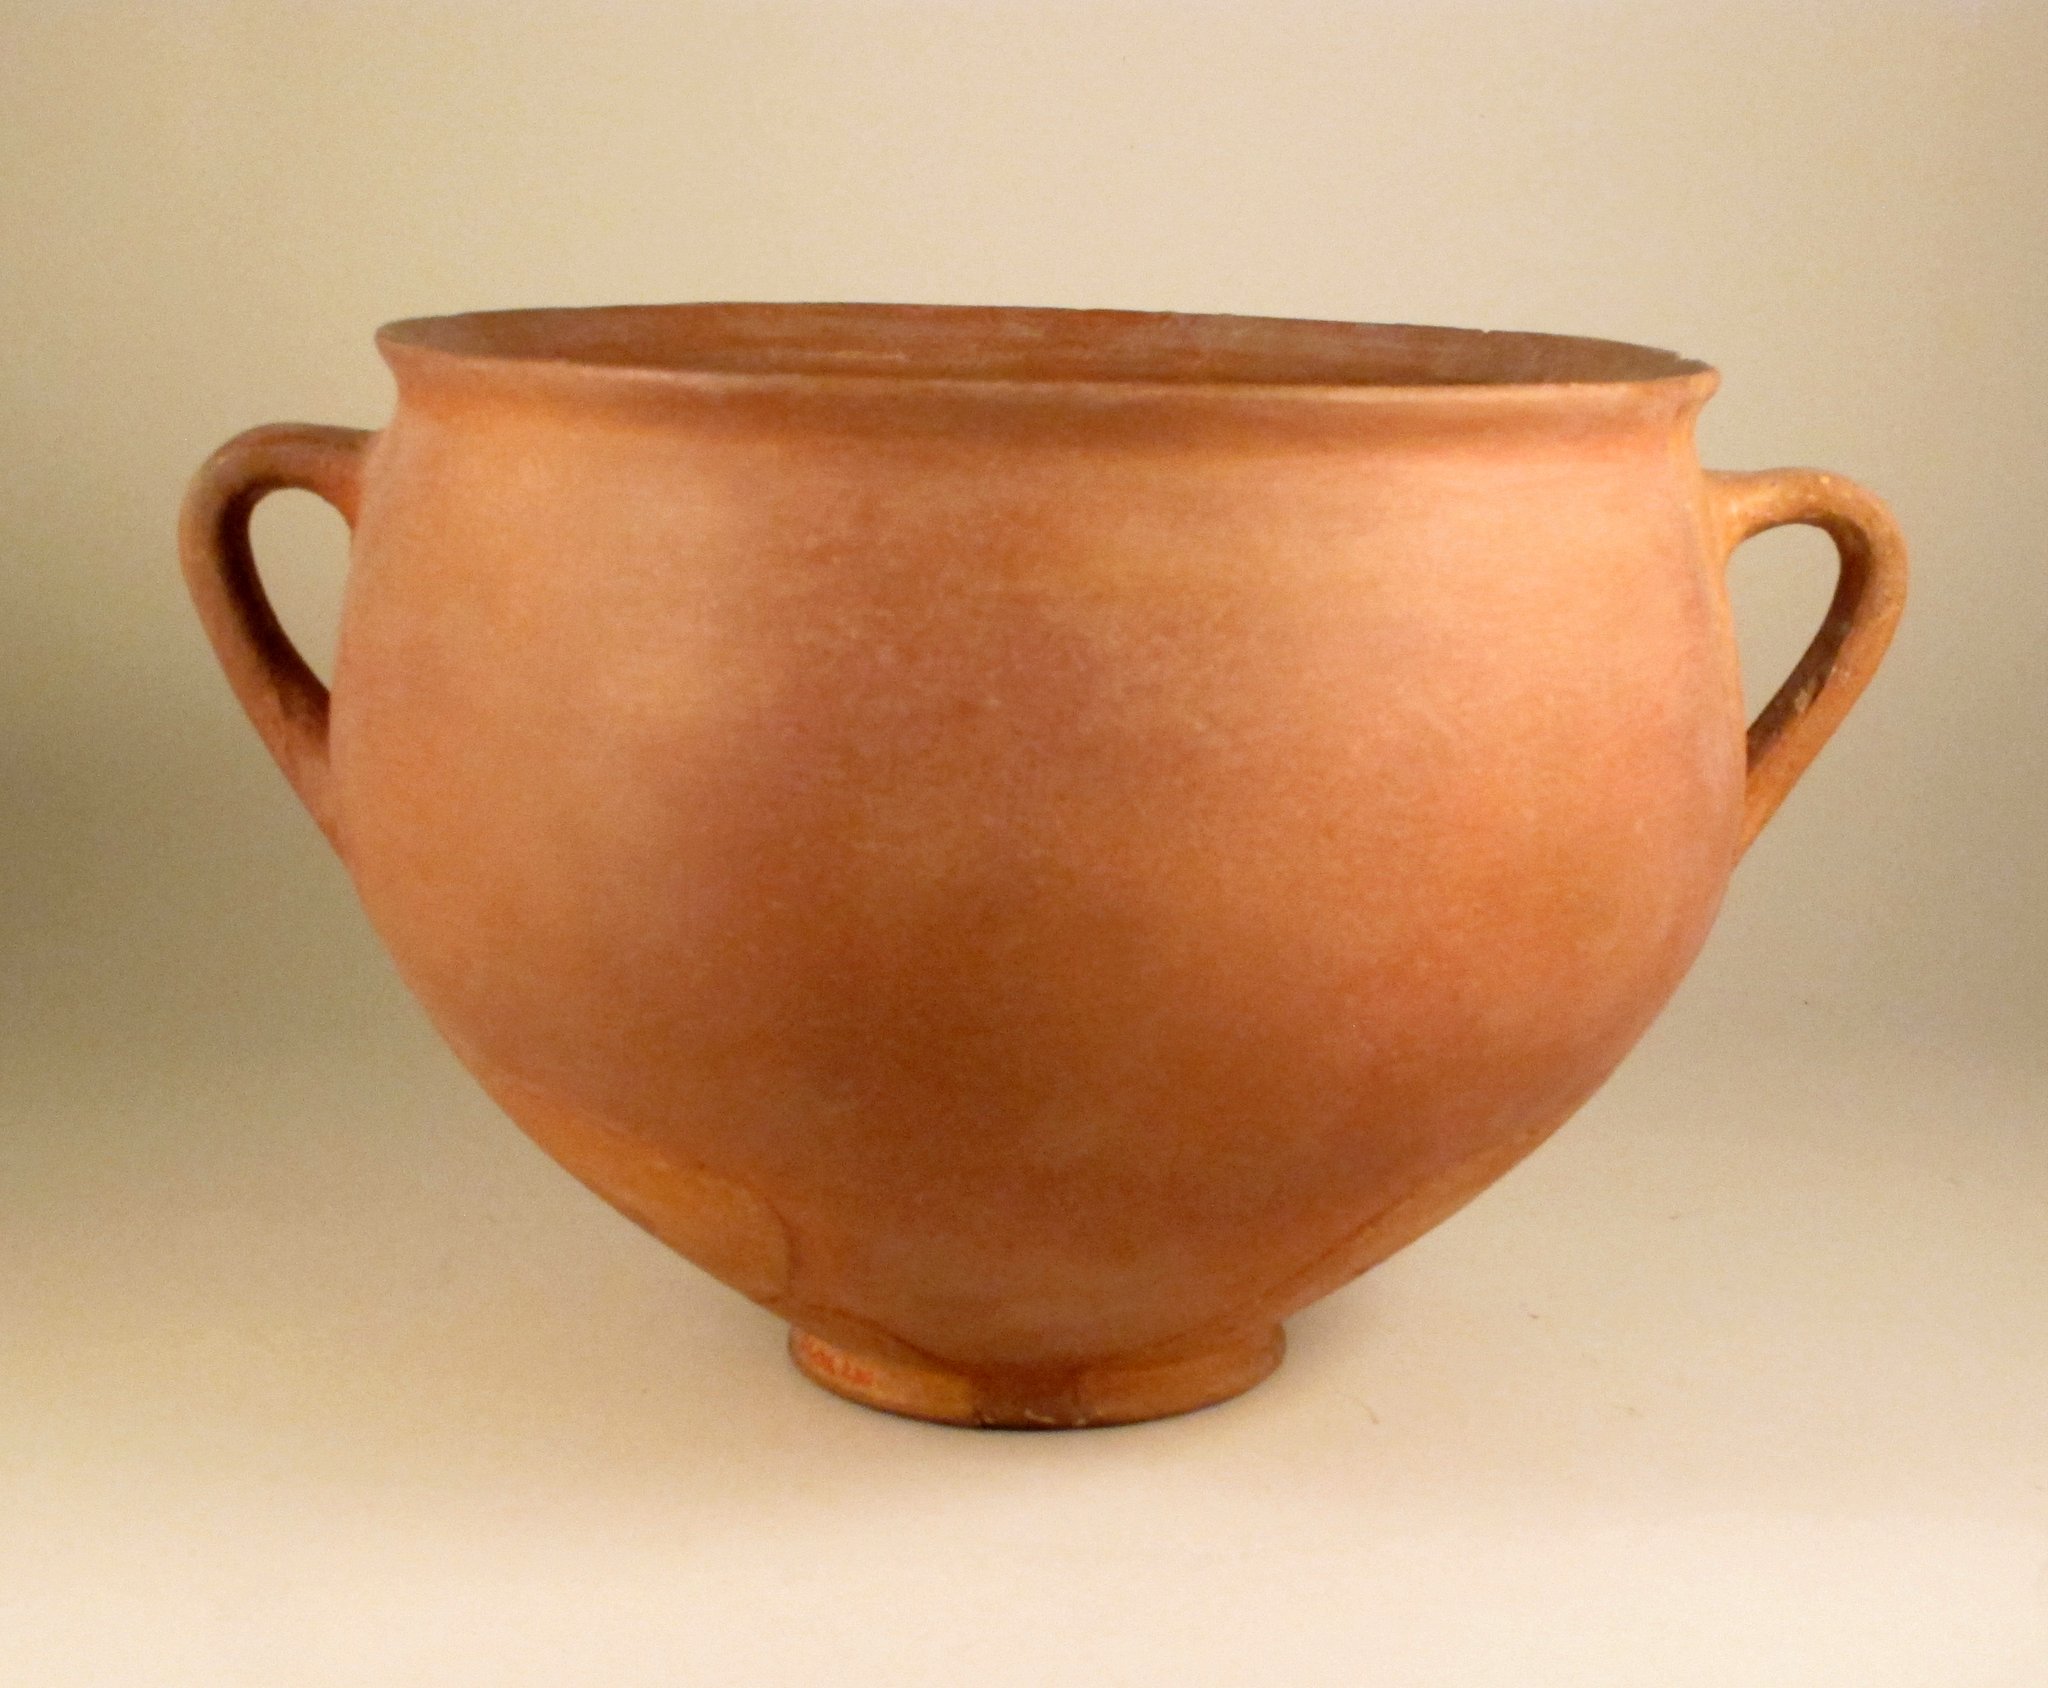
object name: skyphos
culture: greek or lydian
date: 900-30 BCE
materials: terracotta